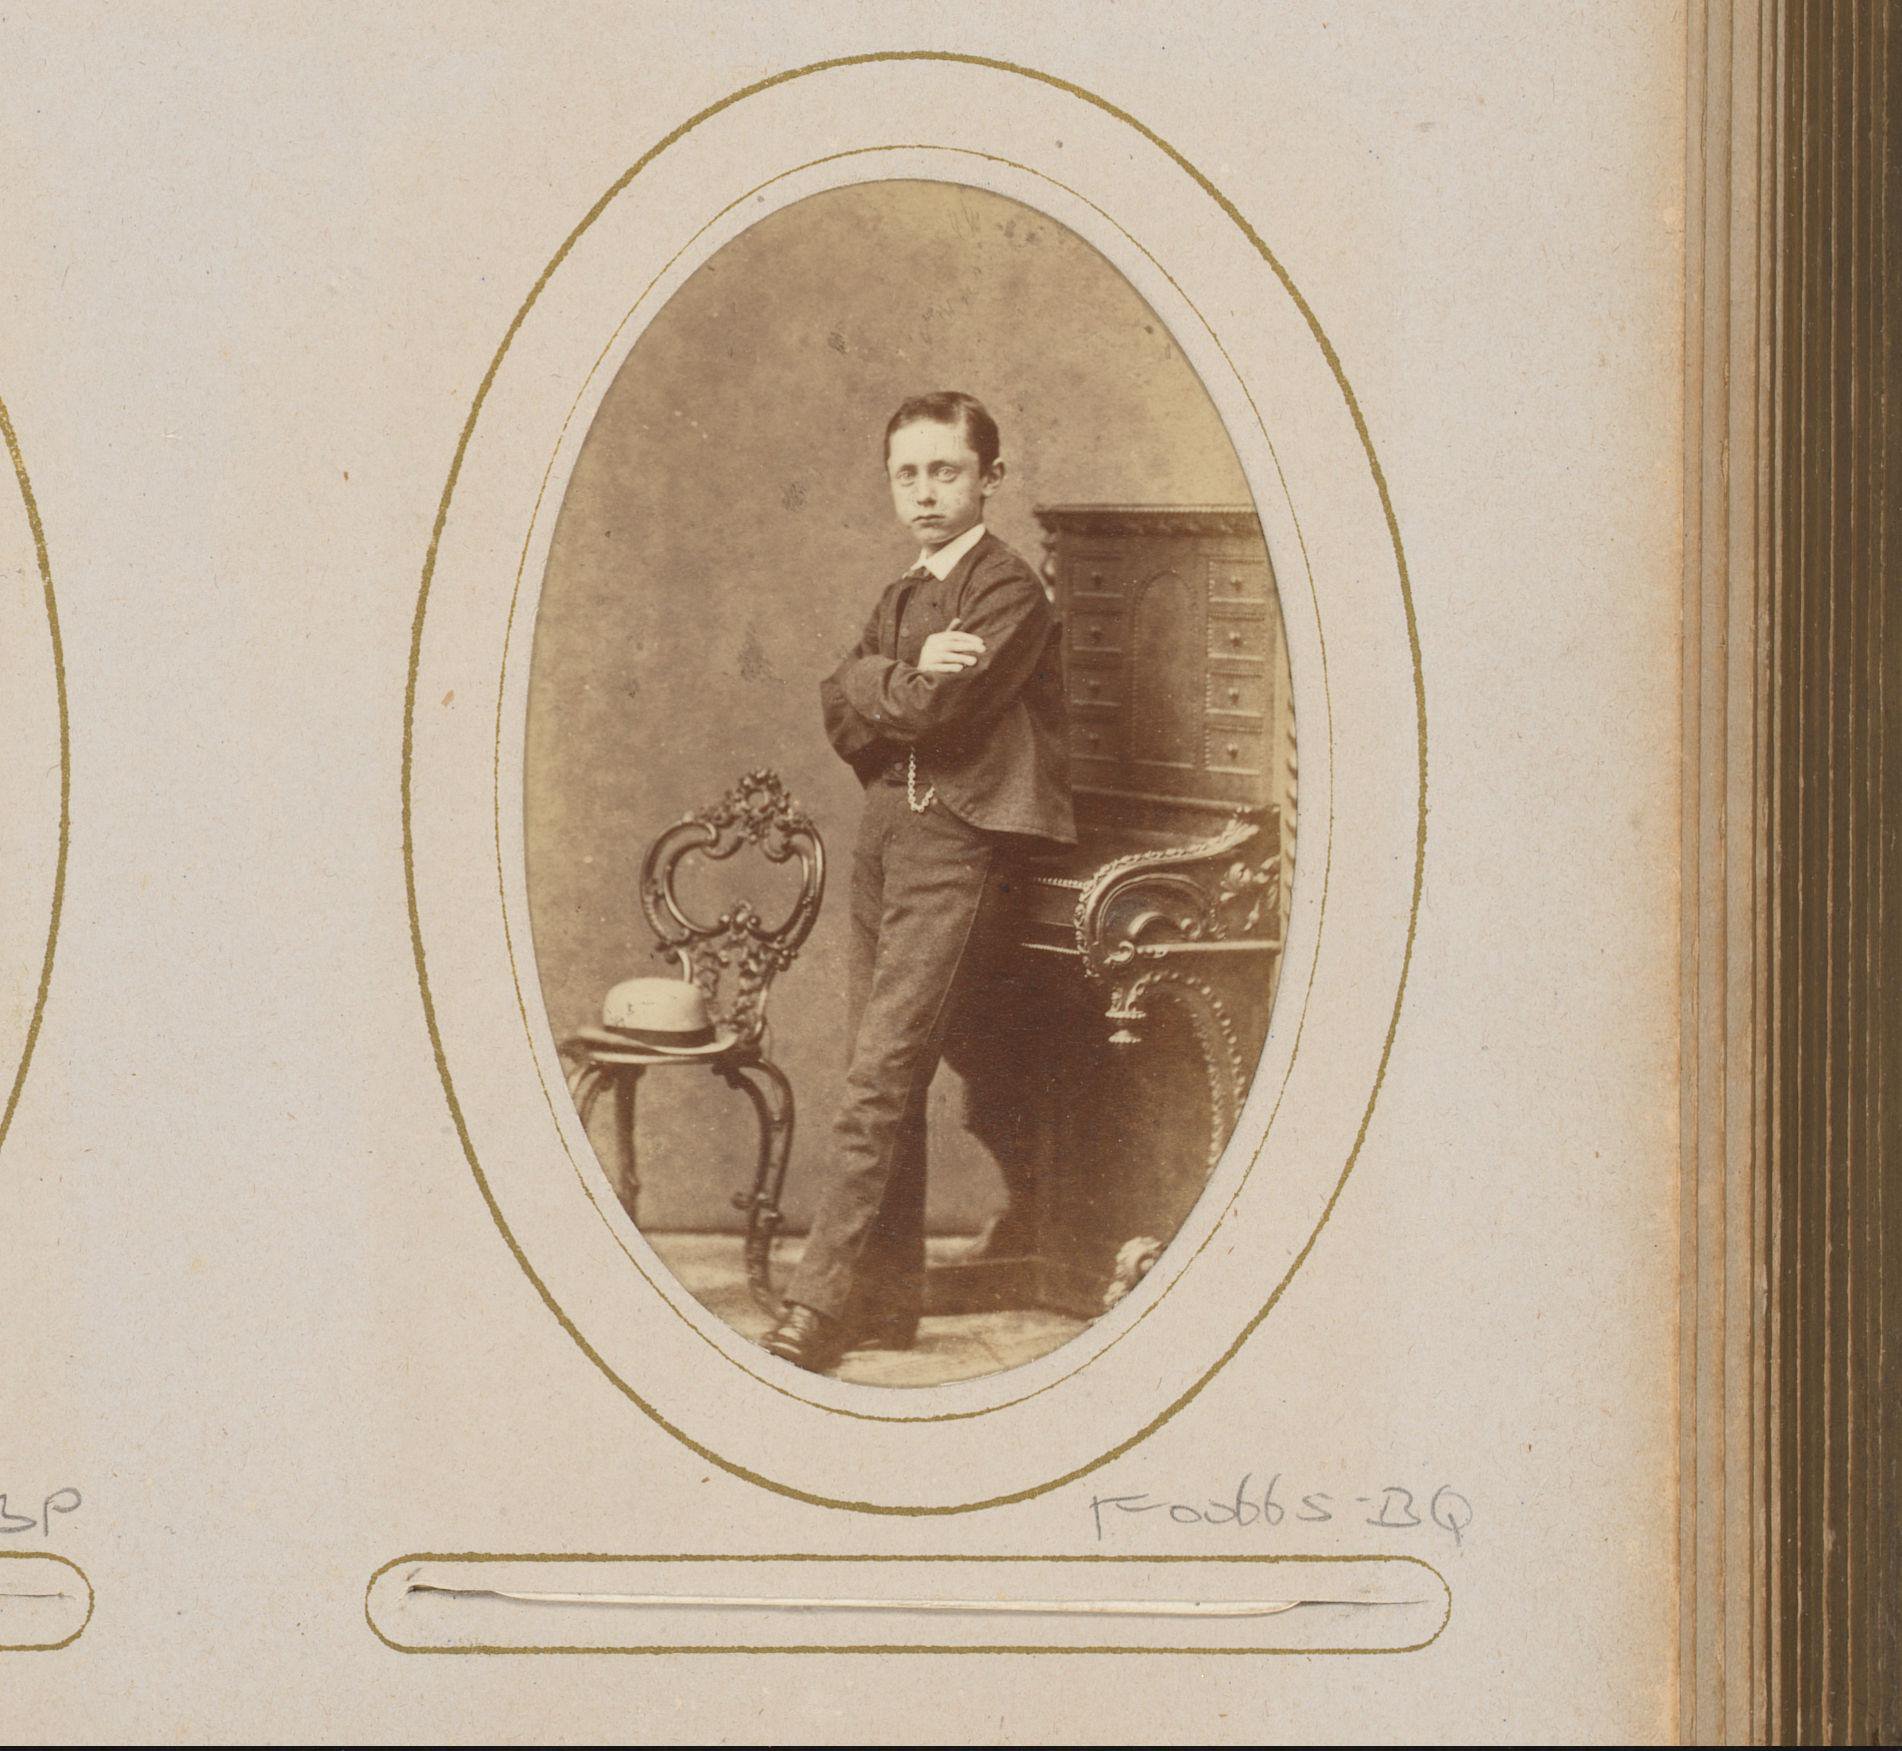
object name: carte de visite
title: Portret van een jongen leunend tegen bureau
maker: thomas martin staas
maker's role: fotograaf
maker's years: 1844-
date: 1865-1895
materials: cardboard, photographic support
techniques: albumen print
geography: leeuwarden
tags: boy (child between toddler and youth)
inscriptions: inscription: ‘Photographie/ Firma/ E. Fuchs/ Opvolger/ Th. M. Staas/ Leeuwarden’